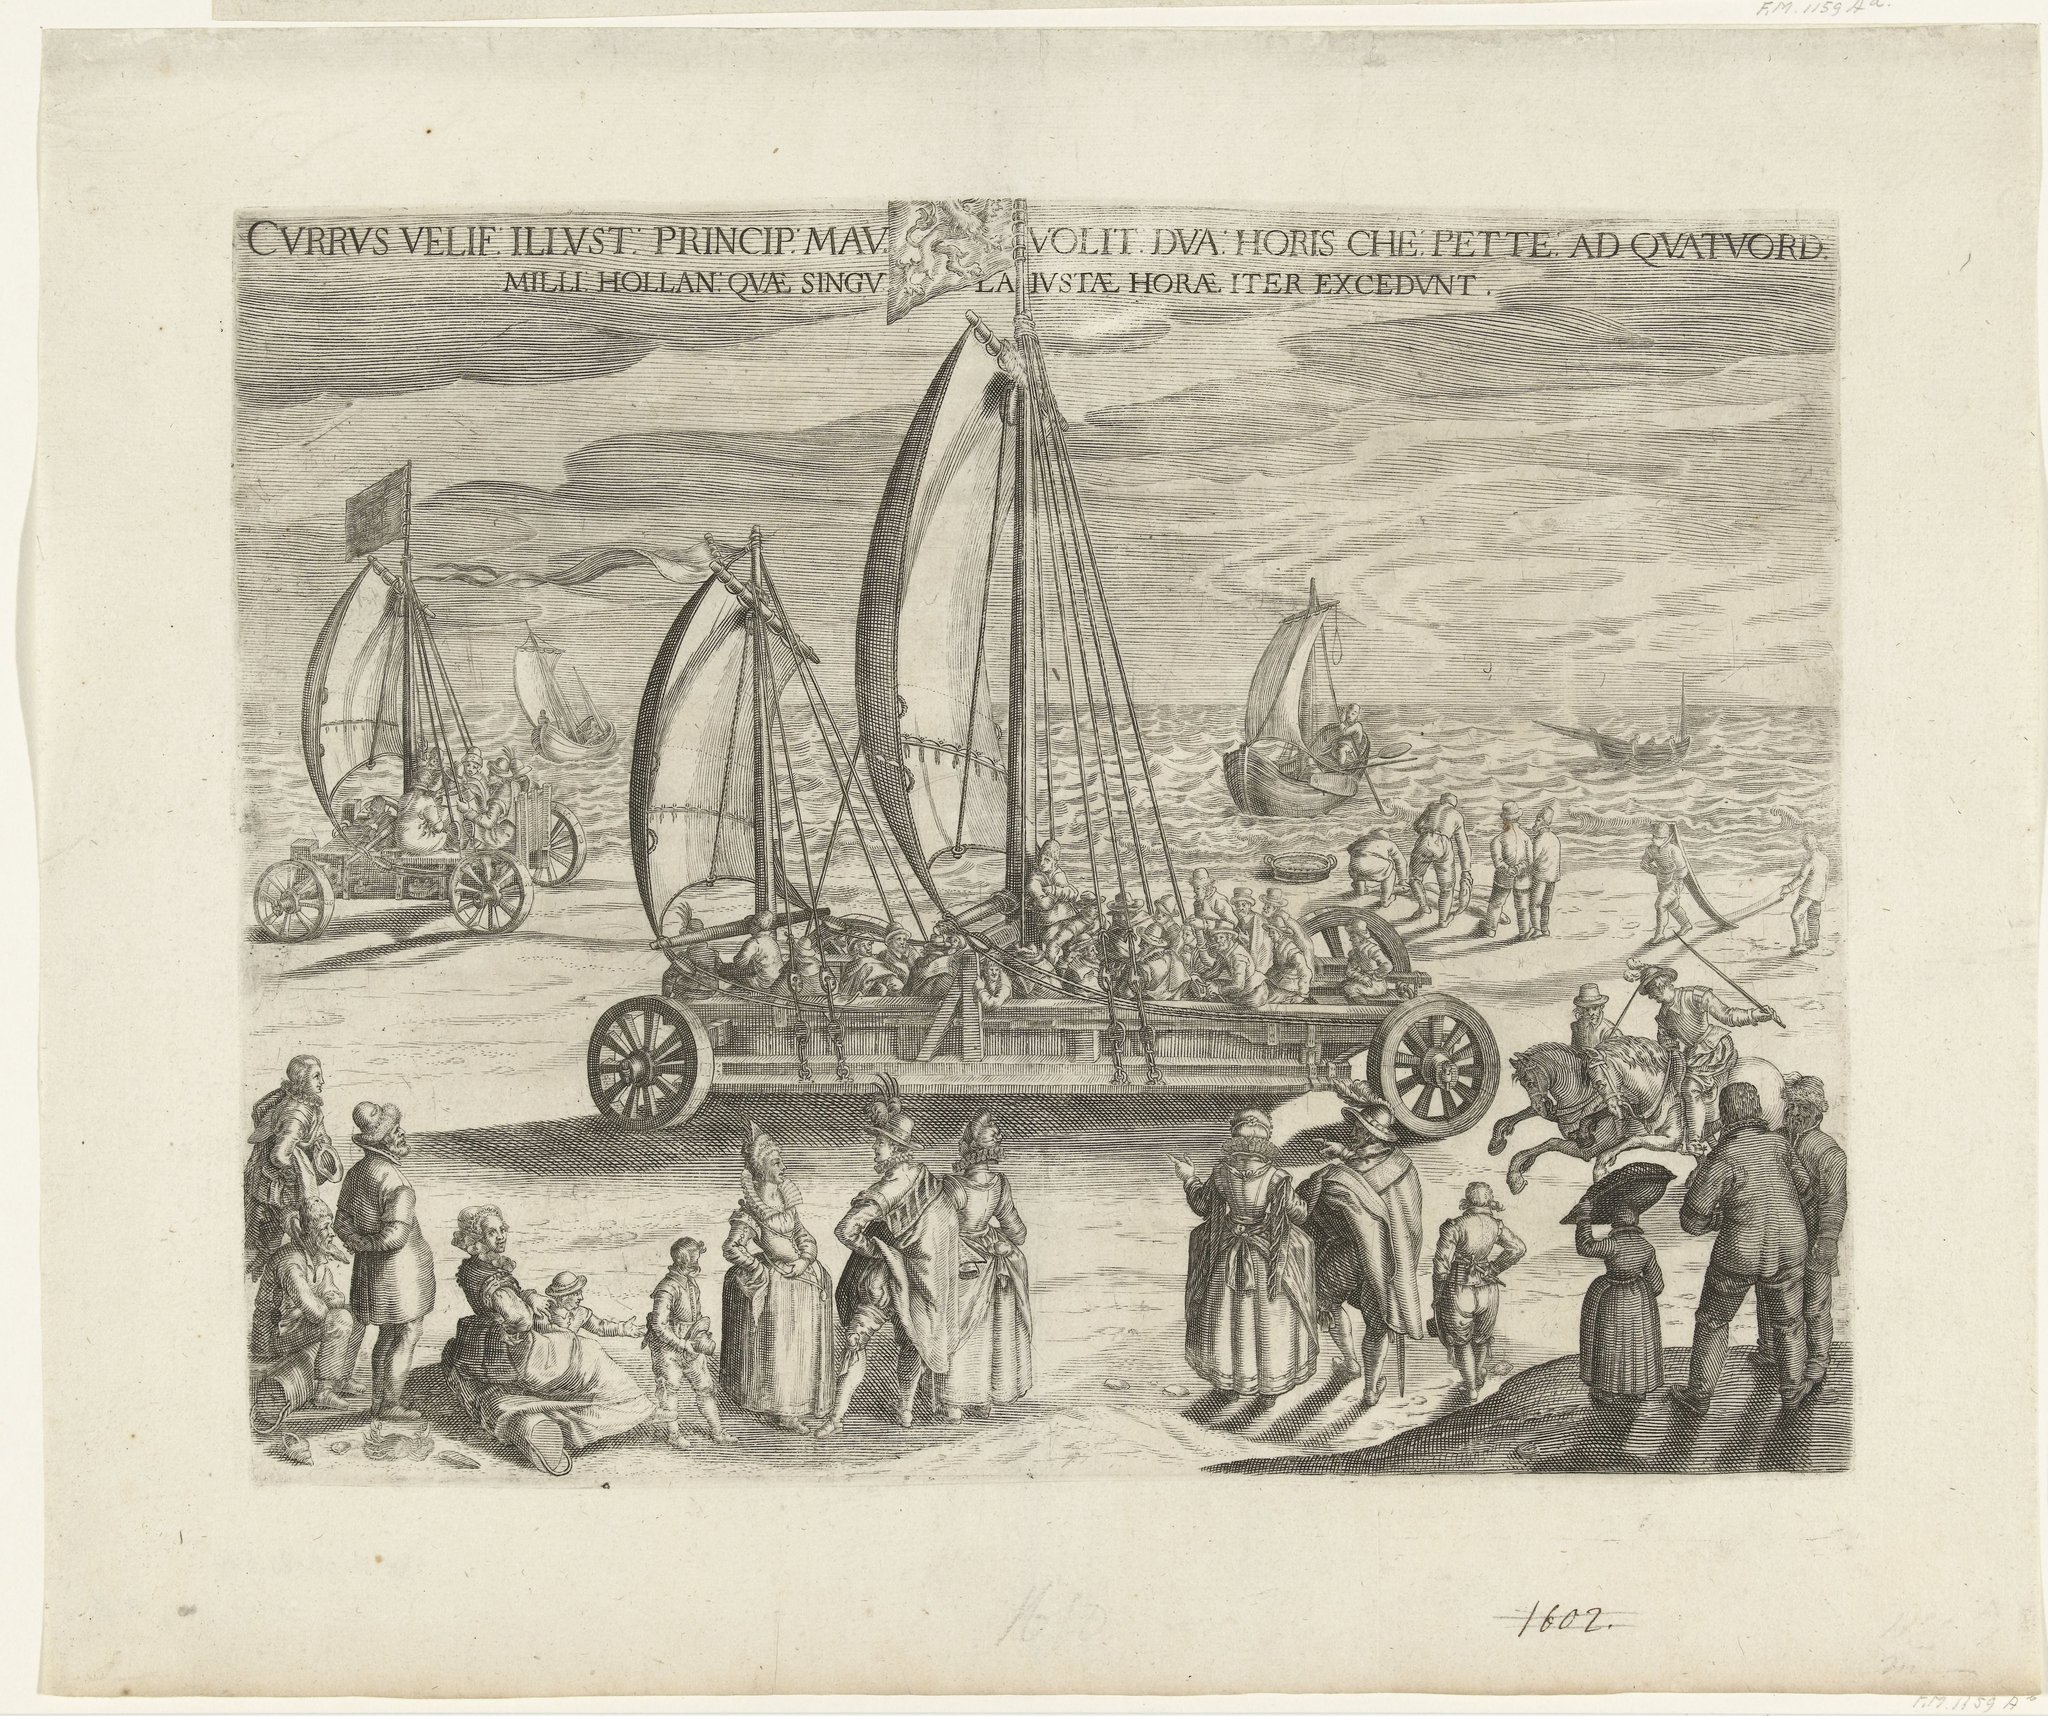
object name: history print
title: De zeilwagen van Simon Stevin, 1602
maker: Anonymous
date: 1603-1649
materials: paper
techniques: engraving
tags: the hague, maurice (prince of orange), bruges, simon stevin, sailing-car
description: De zeilwagen van Simon Stevin, 1602. Prins Maurits maakt samen met een groep vrienden een tocht over het strand van Scheveningen naar Petten in de zeilwagen gebouwd door Simon Stevin, april-mei 1602. Links een kleine zeilwagen, waarschijnlijk een prototype, met enkele personen aan boord. Op het strand verschillende elegante toeschouwers en enkele vissers. Zonder de Duitse teksten onder de plaat.